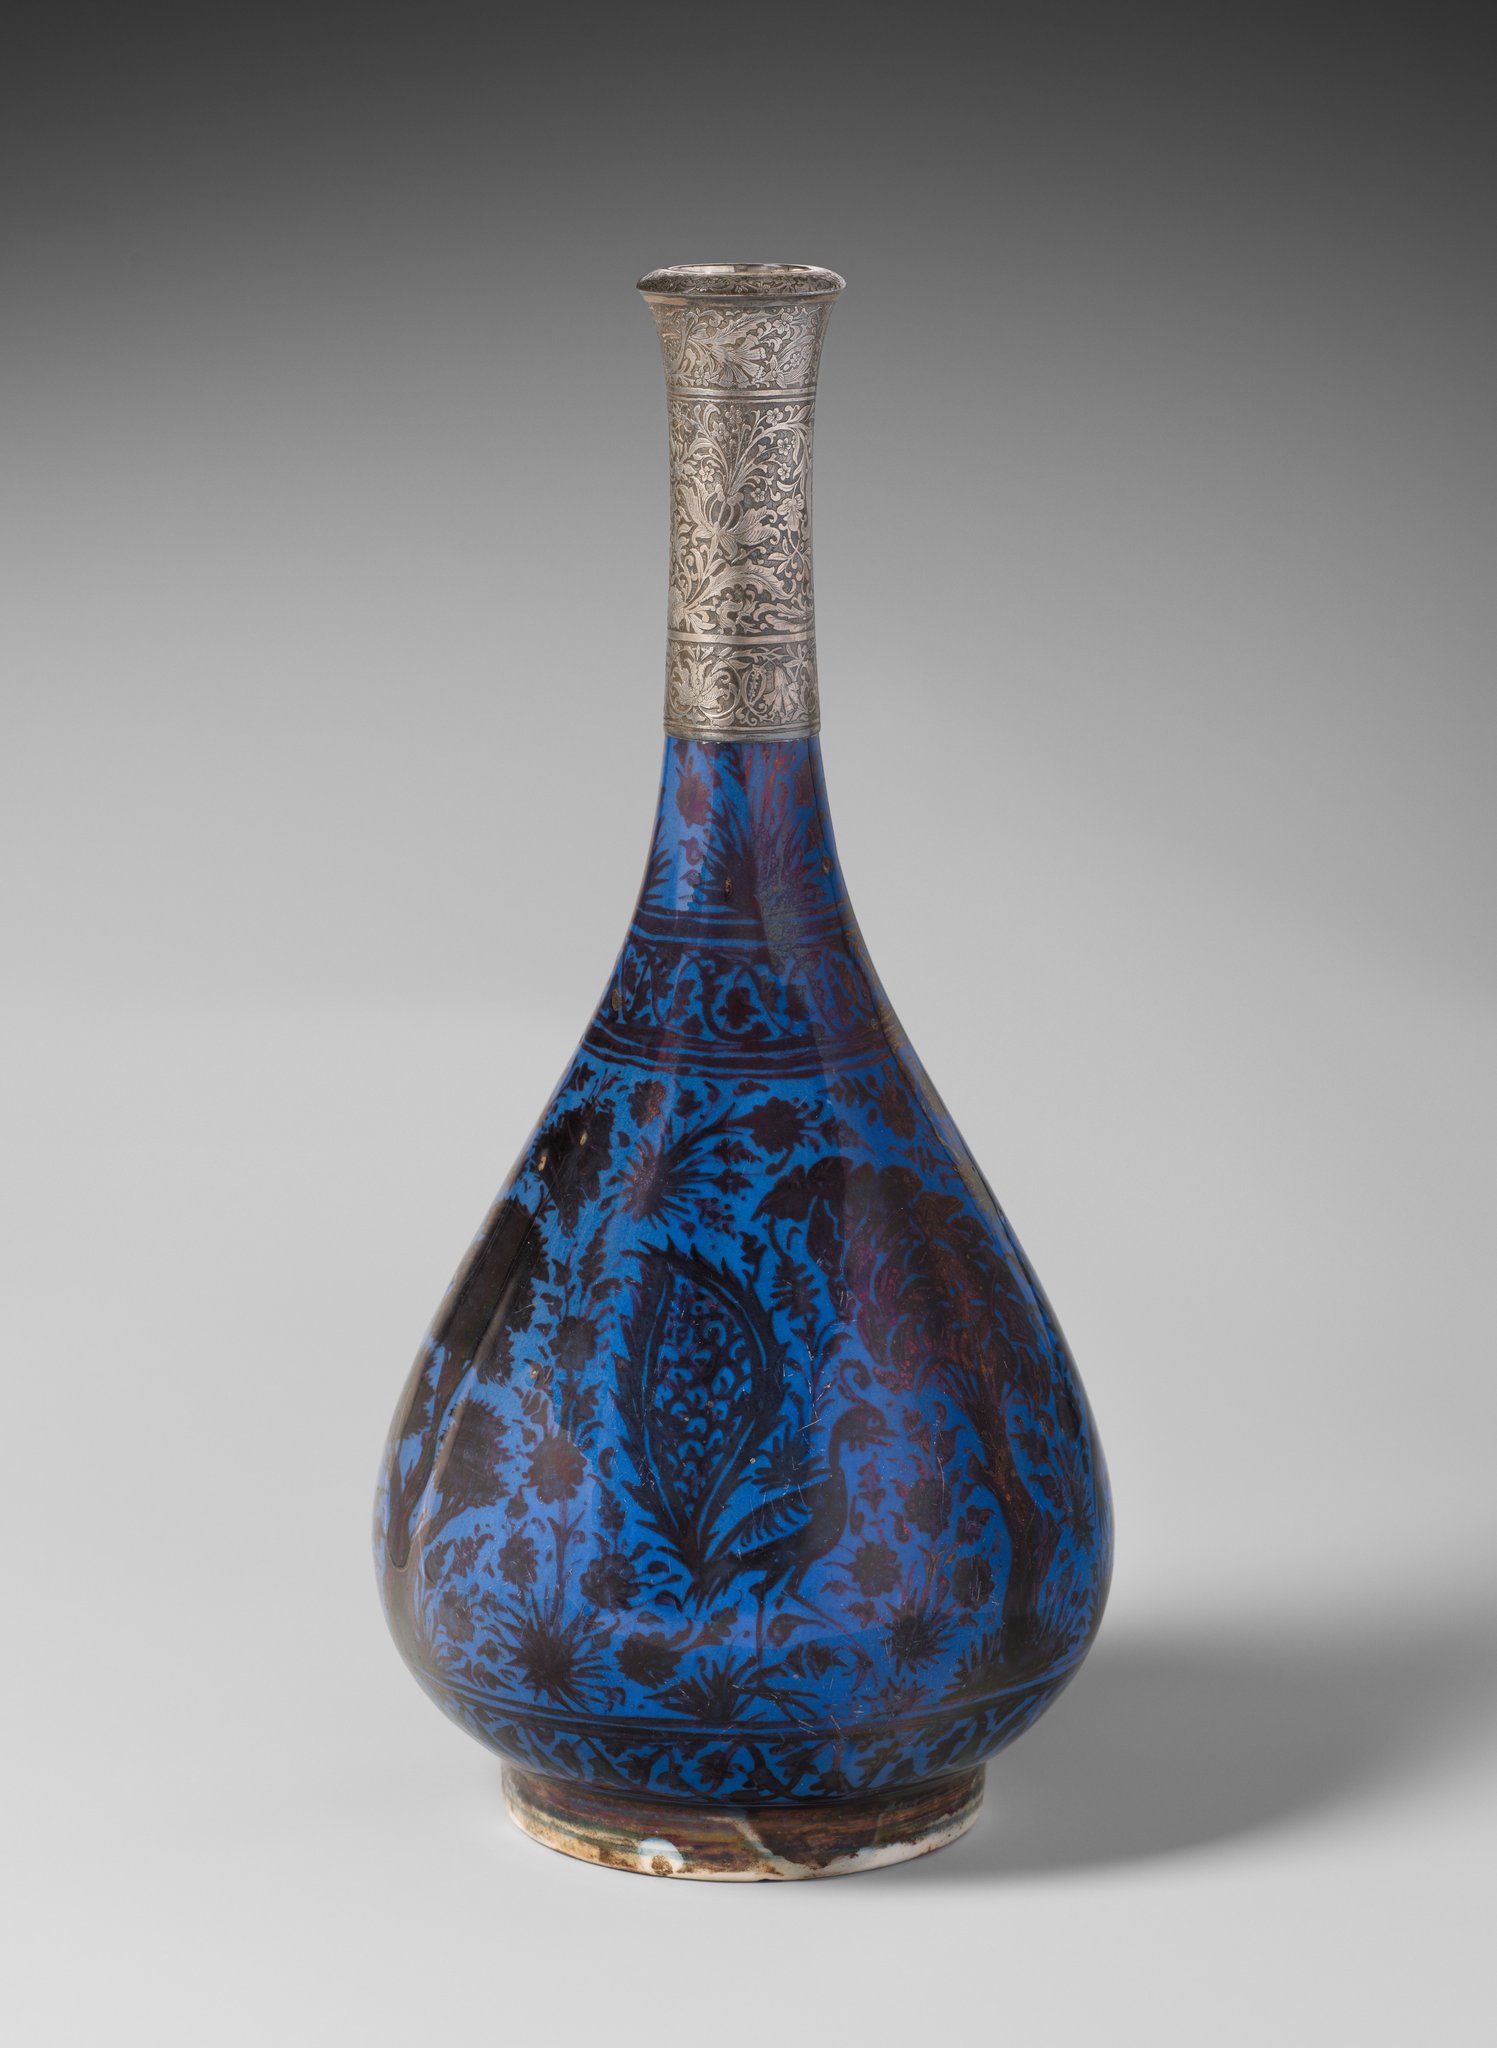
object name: bottle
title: Bottle Depicting a Peacock in Foliage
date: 1601-1700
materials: glaze, silver, stonepaste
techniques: luster painting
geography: iran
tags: peacocks